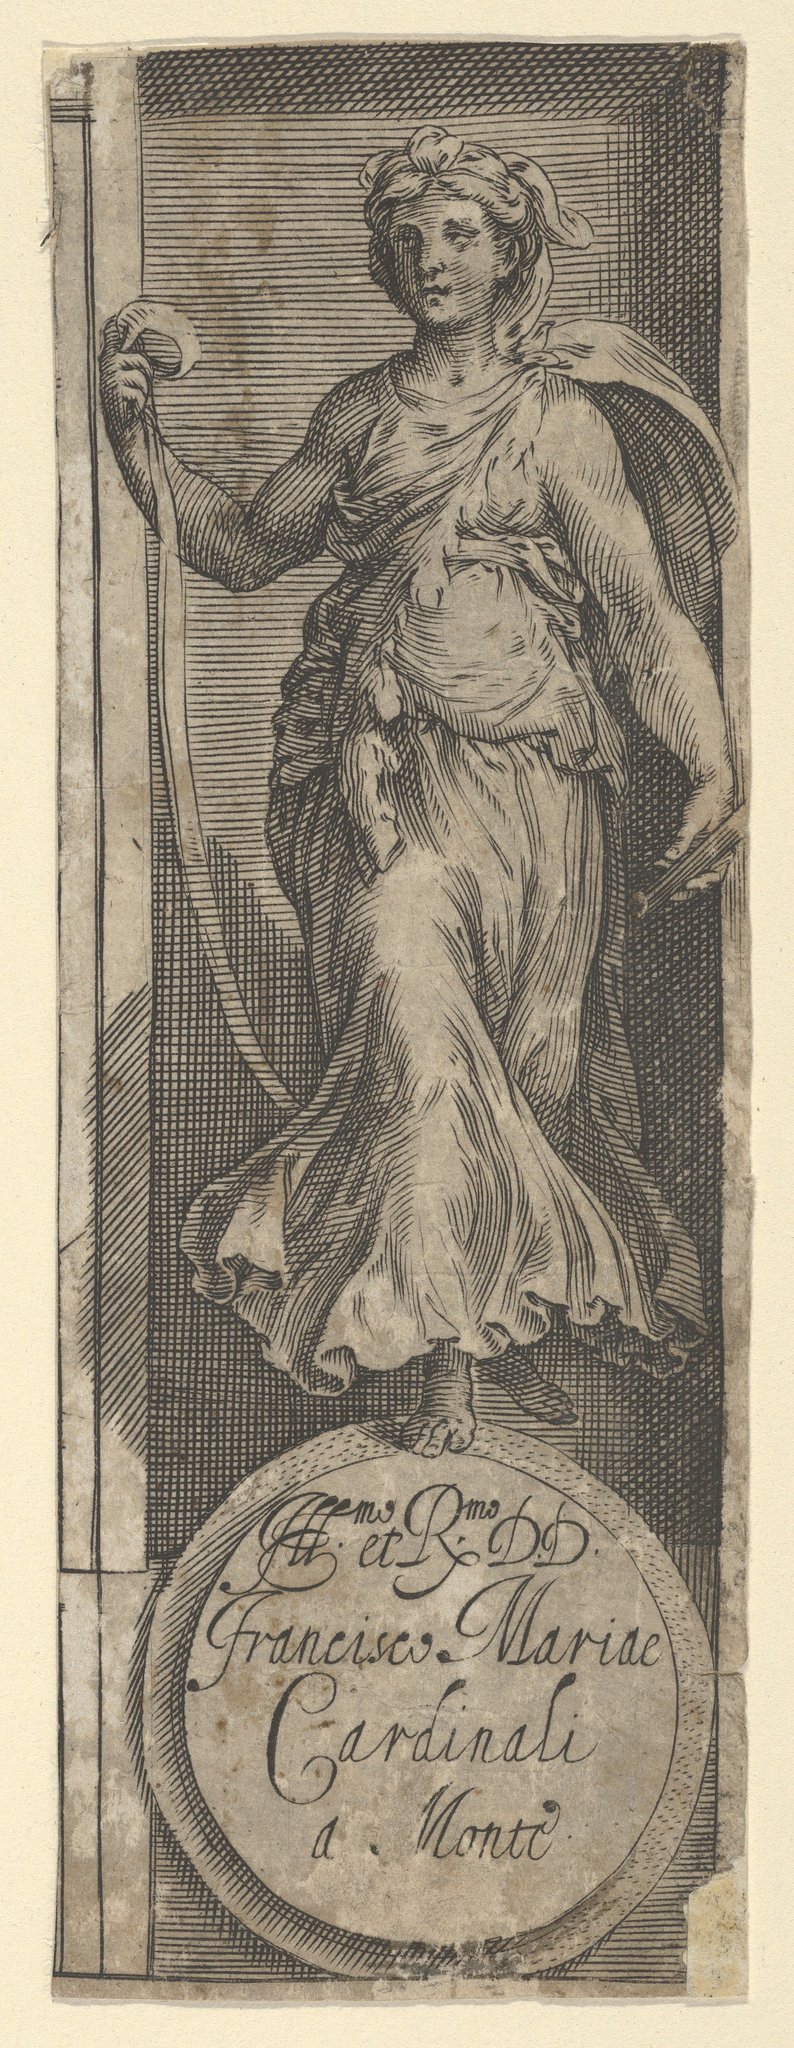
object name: print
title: Female figure standing in the right-hand margin of the third sheet of the Rape of the Sabine Women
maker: cherubino alberti (zaccaria mattia)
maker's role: artist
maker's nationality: italian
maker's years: 1553-1615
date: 1570-1615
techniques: engraving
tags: women